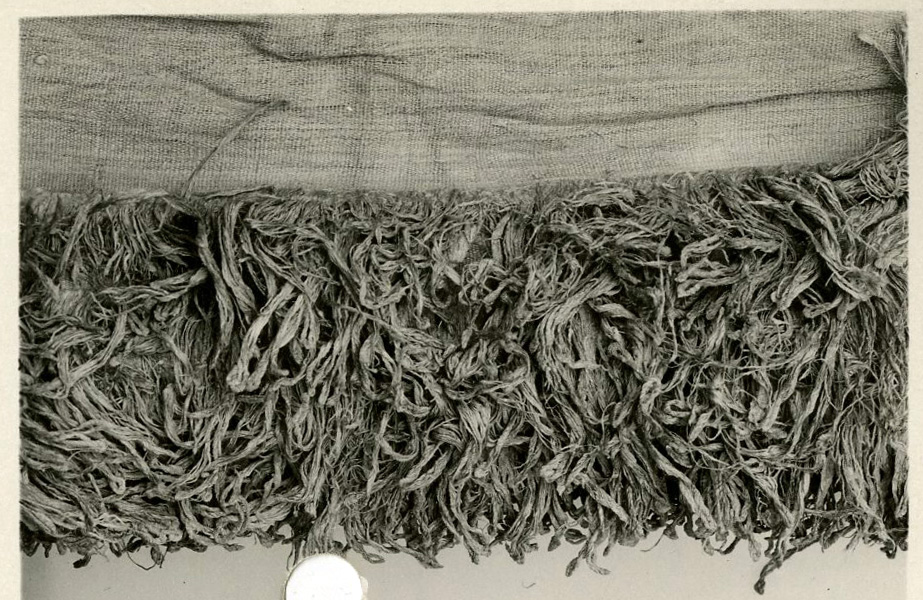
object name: linen sheet, aashyt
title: Linen sheet of Aashyt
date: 2051-2030 BCE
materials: linen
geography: egypt